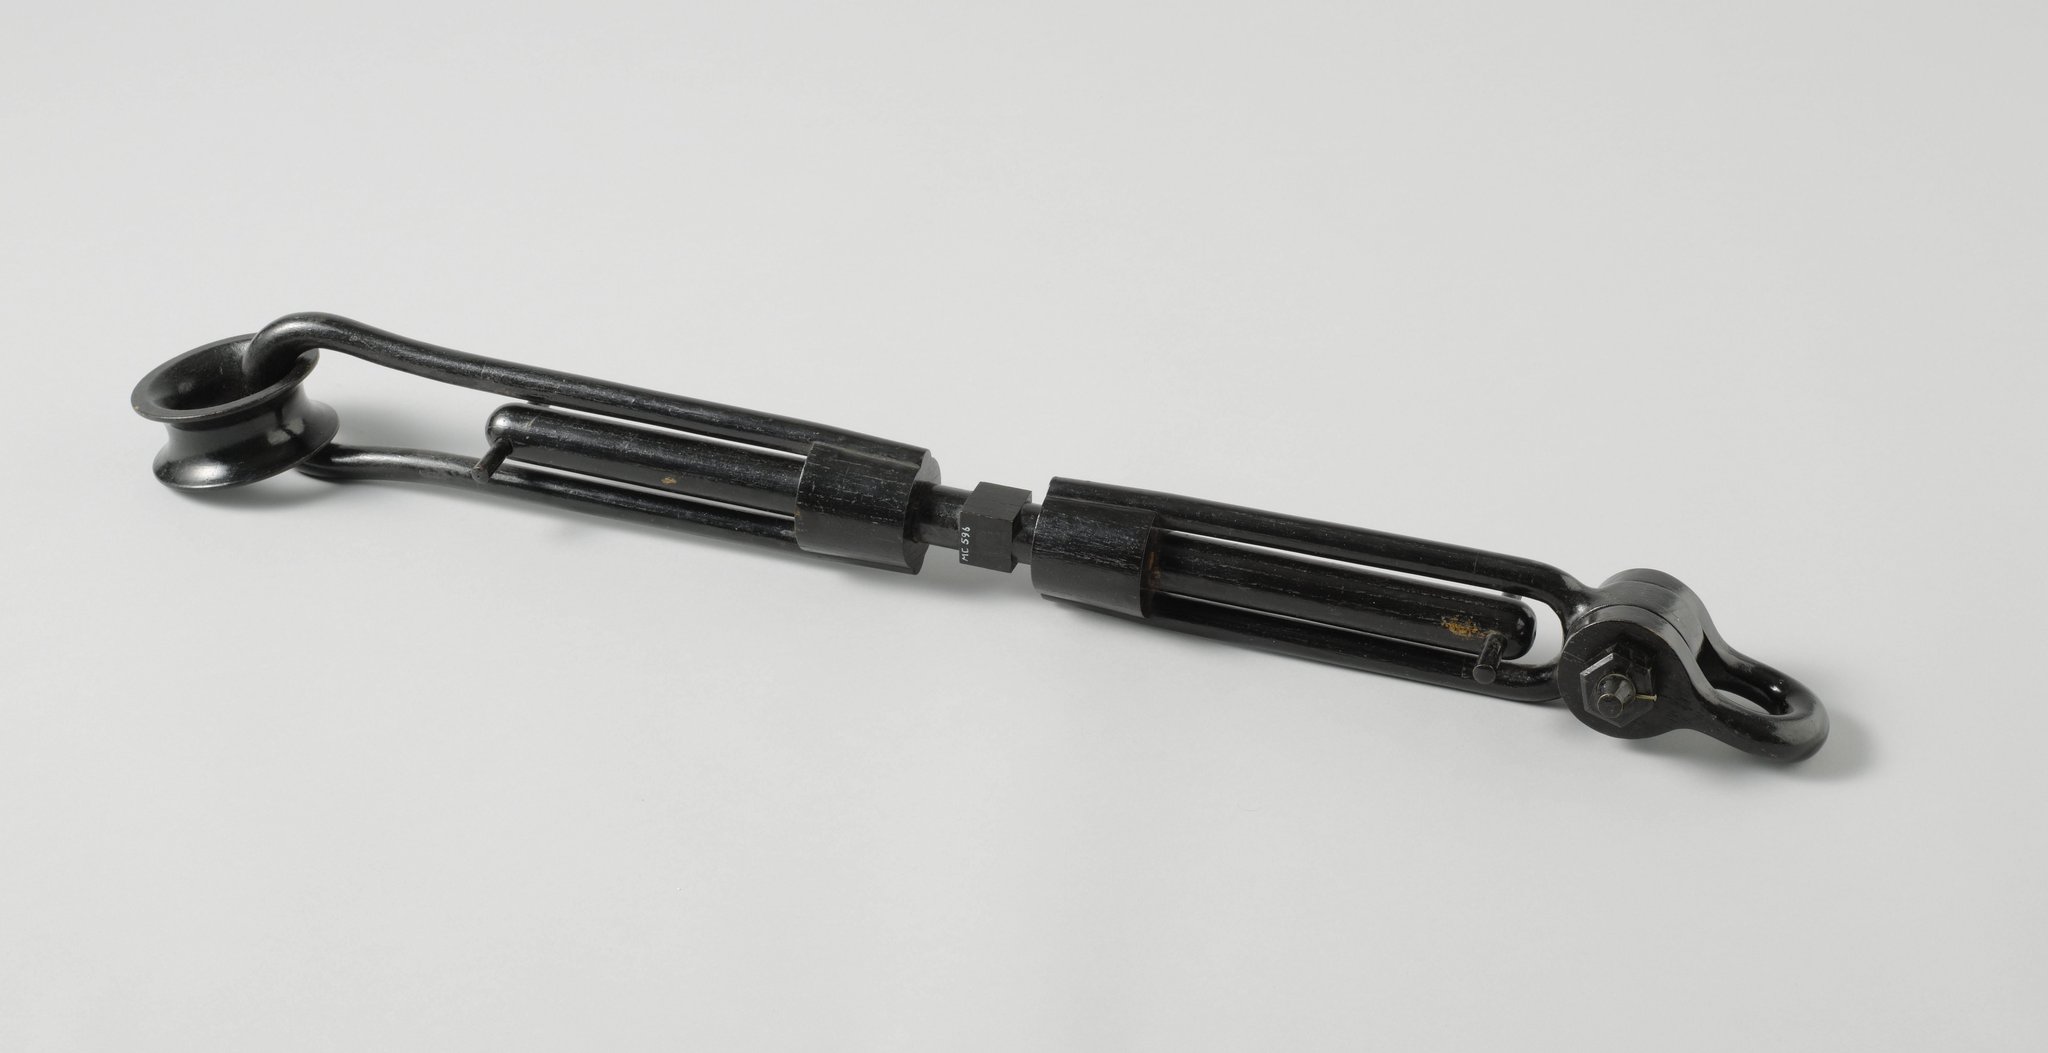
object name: demonstration model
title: Model of a Turnbuckle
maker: Anonymous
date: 1858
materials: paint, wood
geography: netherlands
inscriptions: inscription, centre, in red paint: ‘Nº 6’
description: Dit model stelt een spanwantschroef nr. 6 voor volgens de bepalingen van 1858. PILAAR beschrijft spanwantschroeven 1 tot en met 5; de nummers slaan op de grootte en de plaats in het tuig.